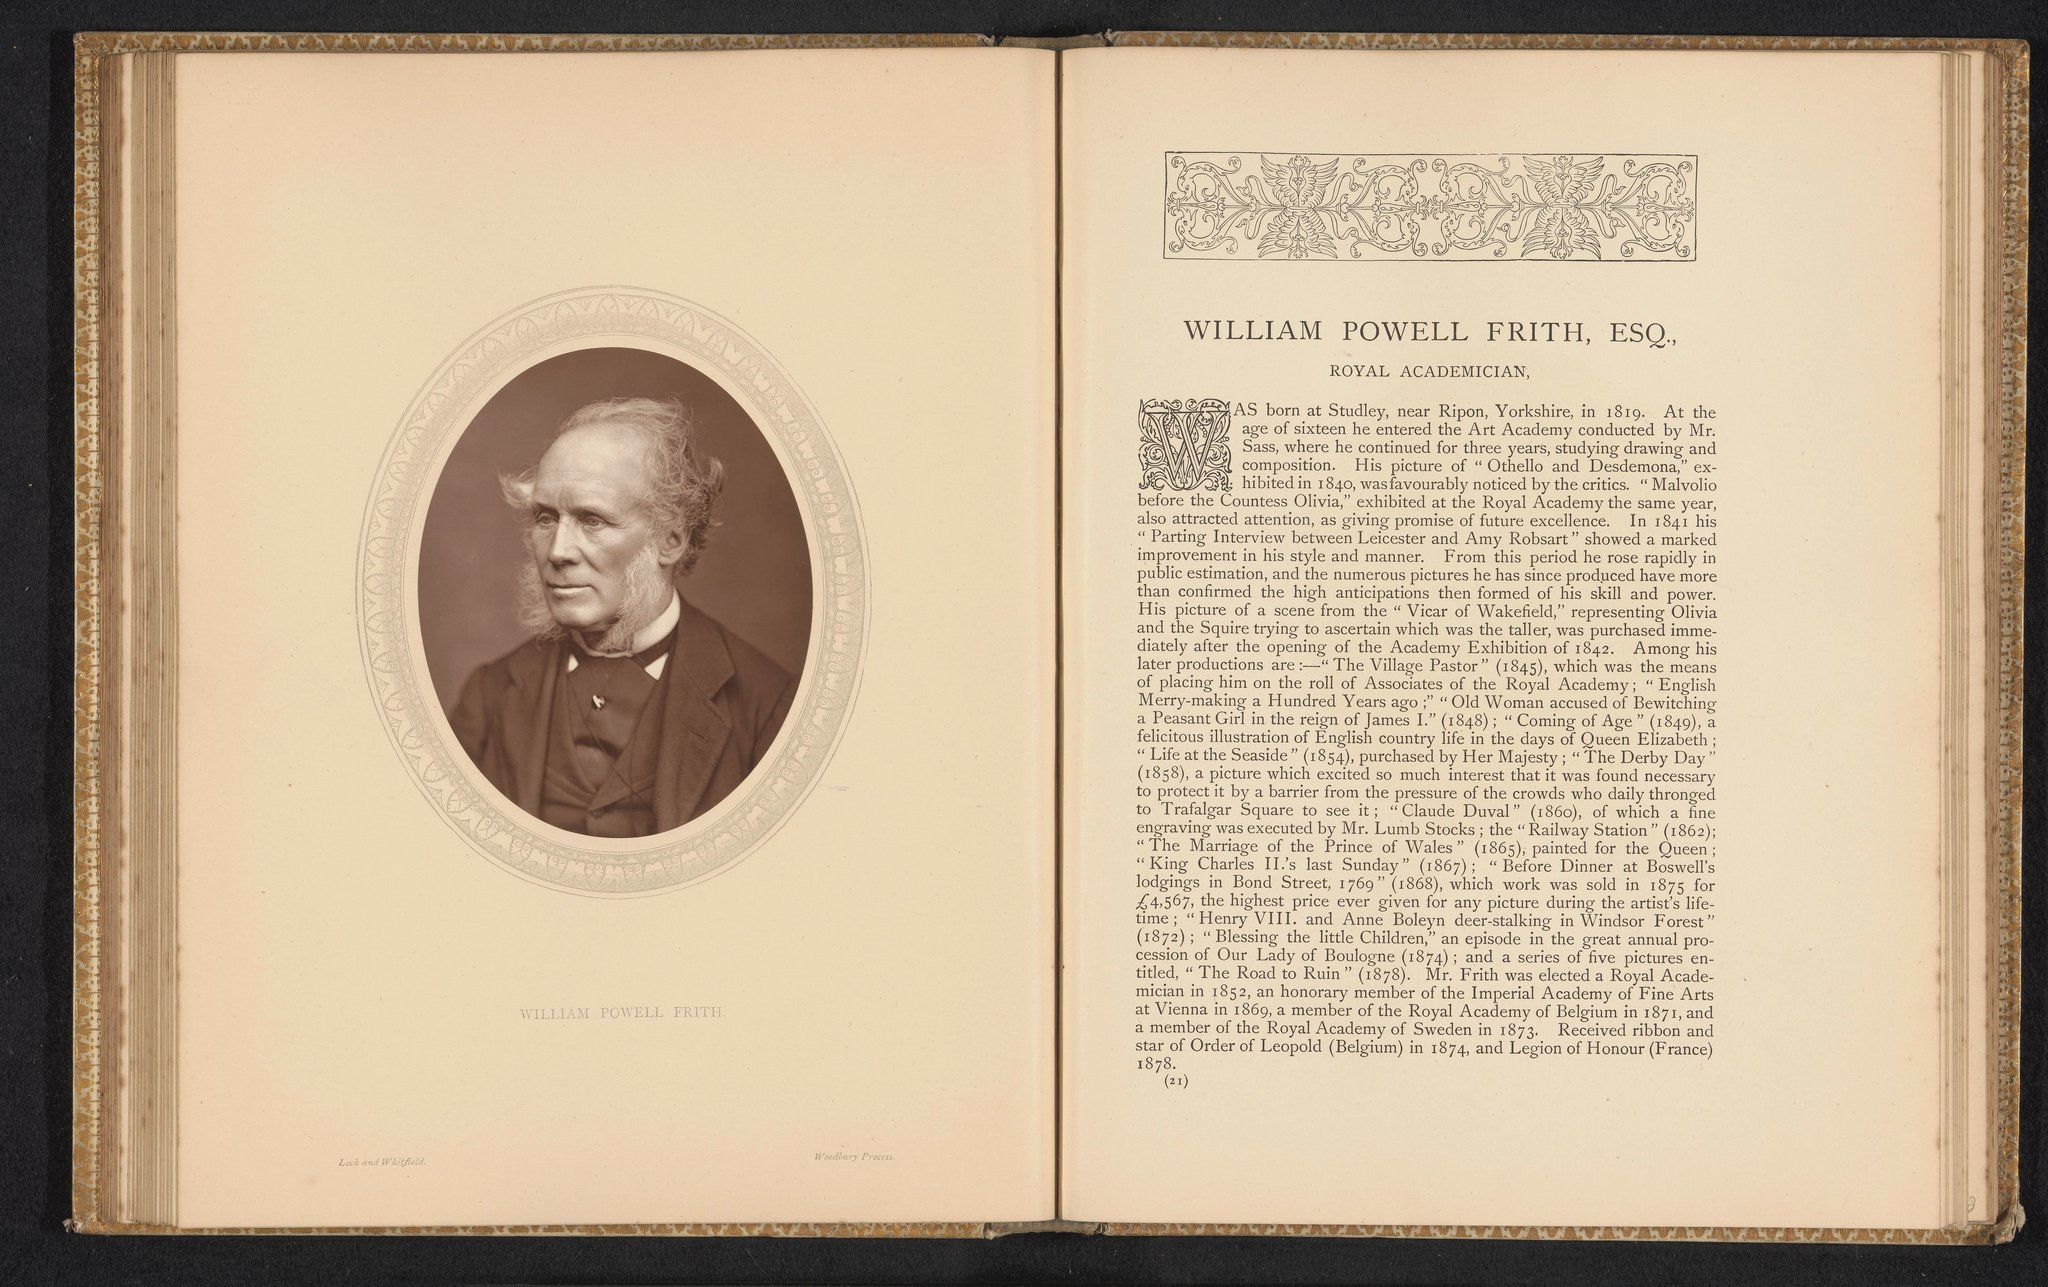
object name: photomechanical print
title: William Powell Frith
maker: Anonymous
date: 1875-1880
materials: paper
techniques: woodburytype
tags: painter, portrait, self-portrait of painter, historical persons (portraits and scenes from the life) (+ (full) bust portrait)